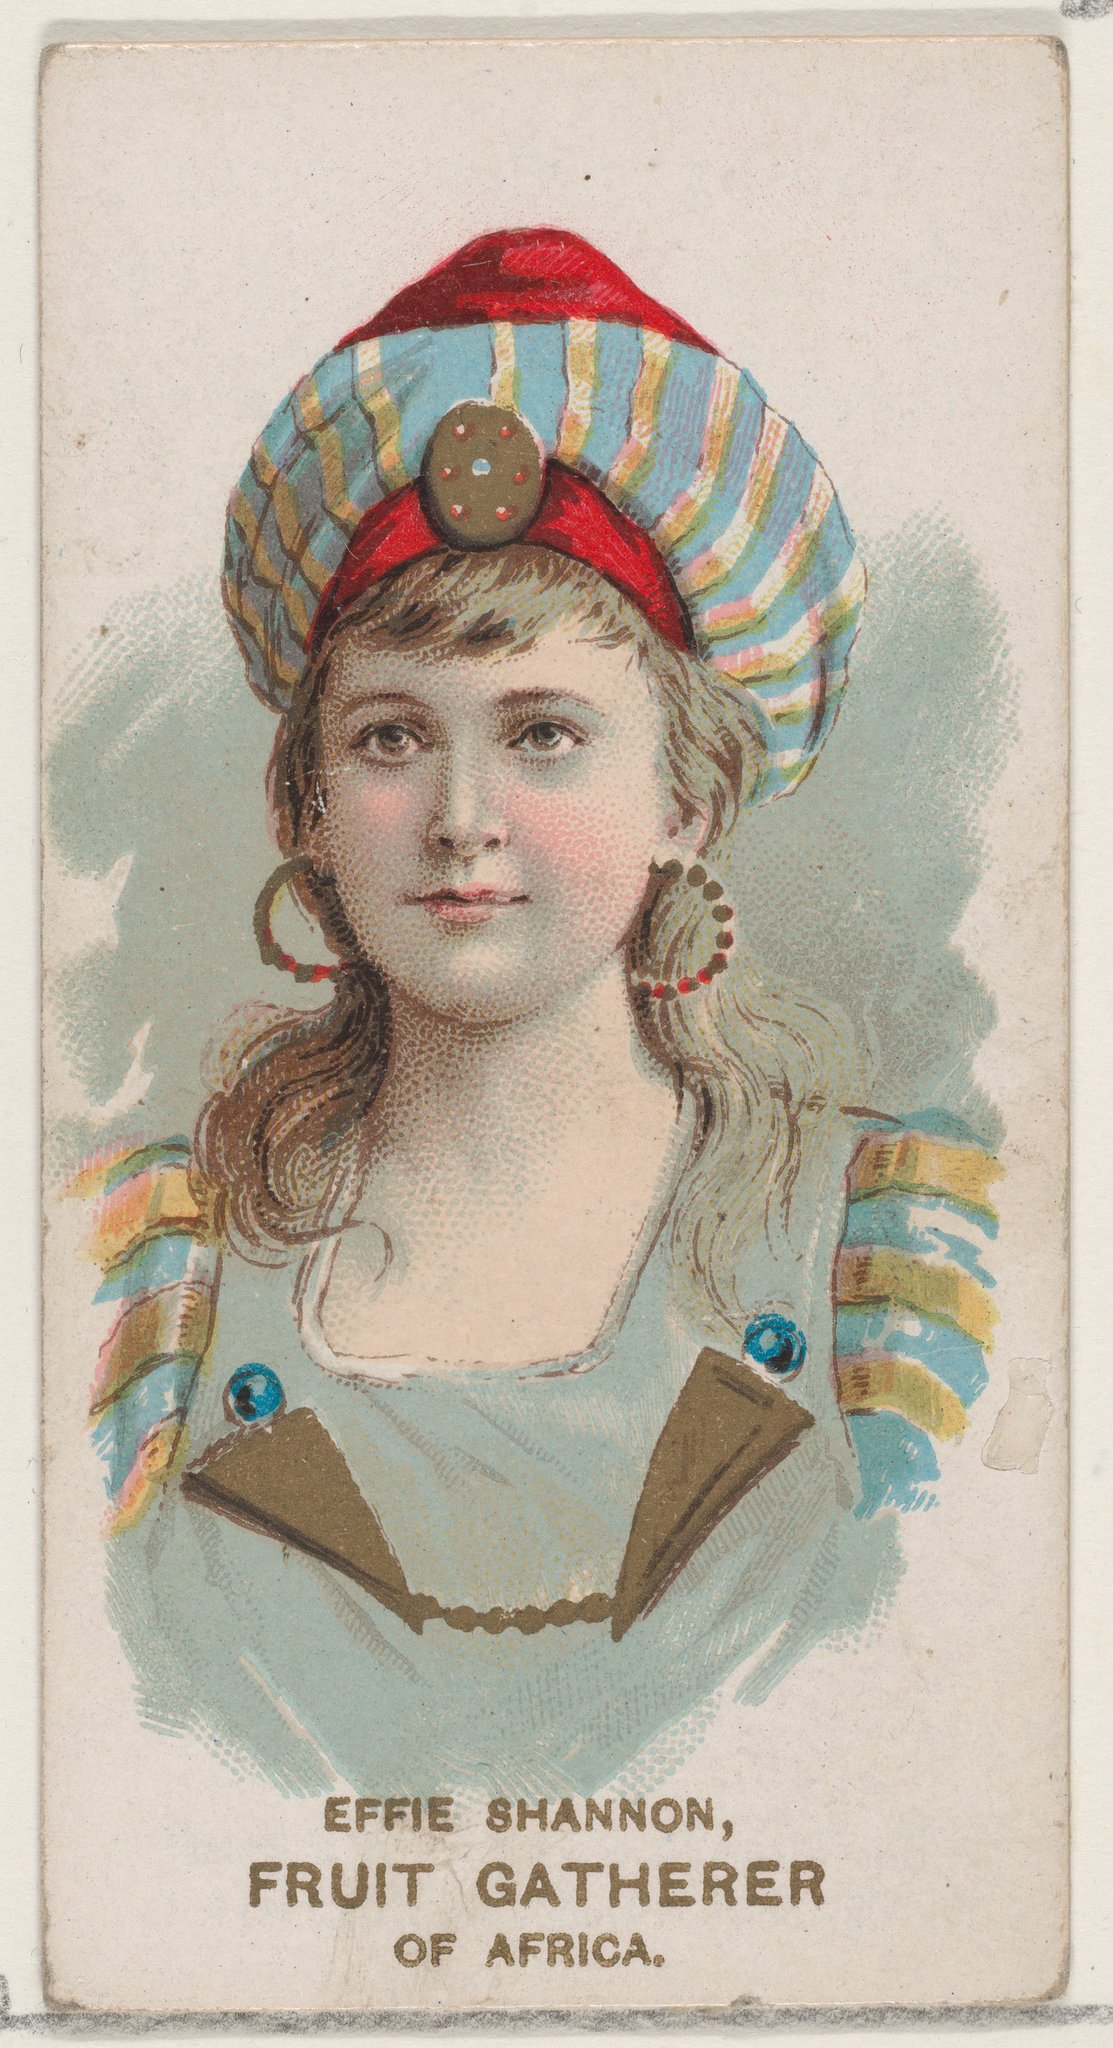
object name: print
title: Effie Shannon Dressed as Fruit Gatherer of Africa, from the set Actors and Actresses, Second Series (N71) for Duke brand cigarettes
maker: w. duke, sons & co.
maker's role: publisher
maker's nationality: american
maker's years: 1870-1920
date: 1888-1890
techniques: color lithograph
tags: women,actresses